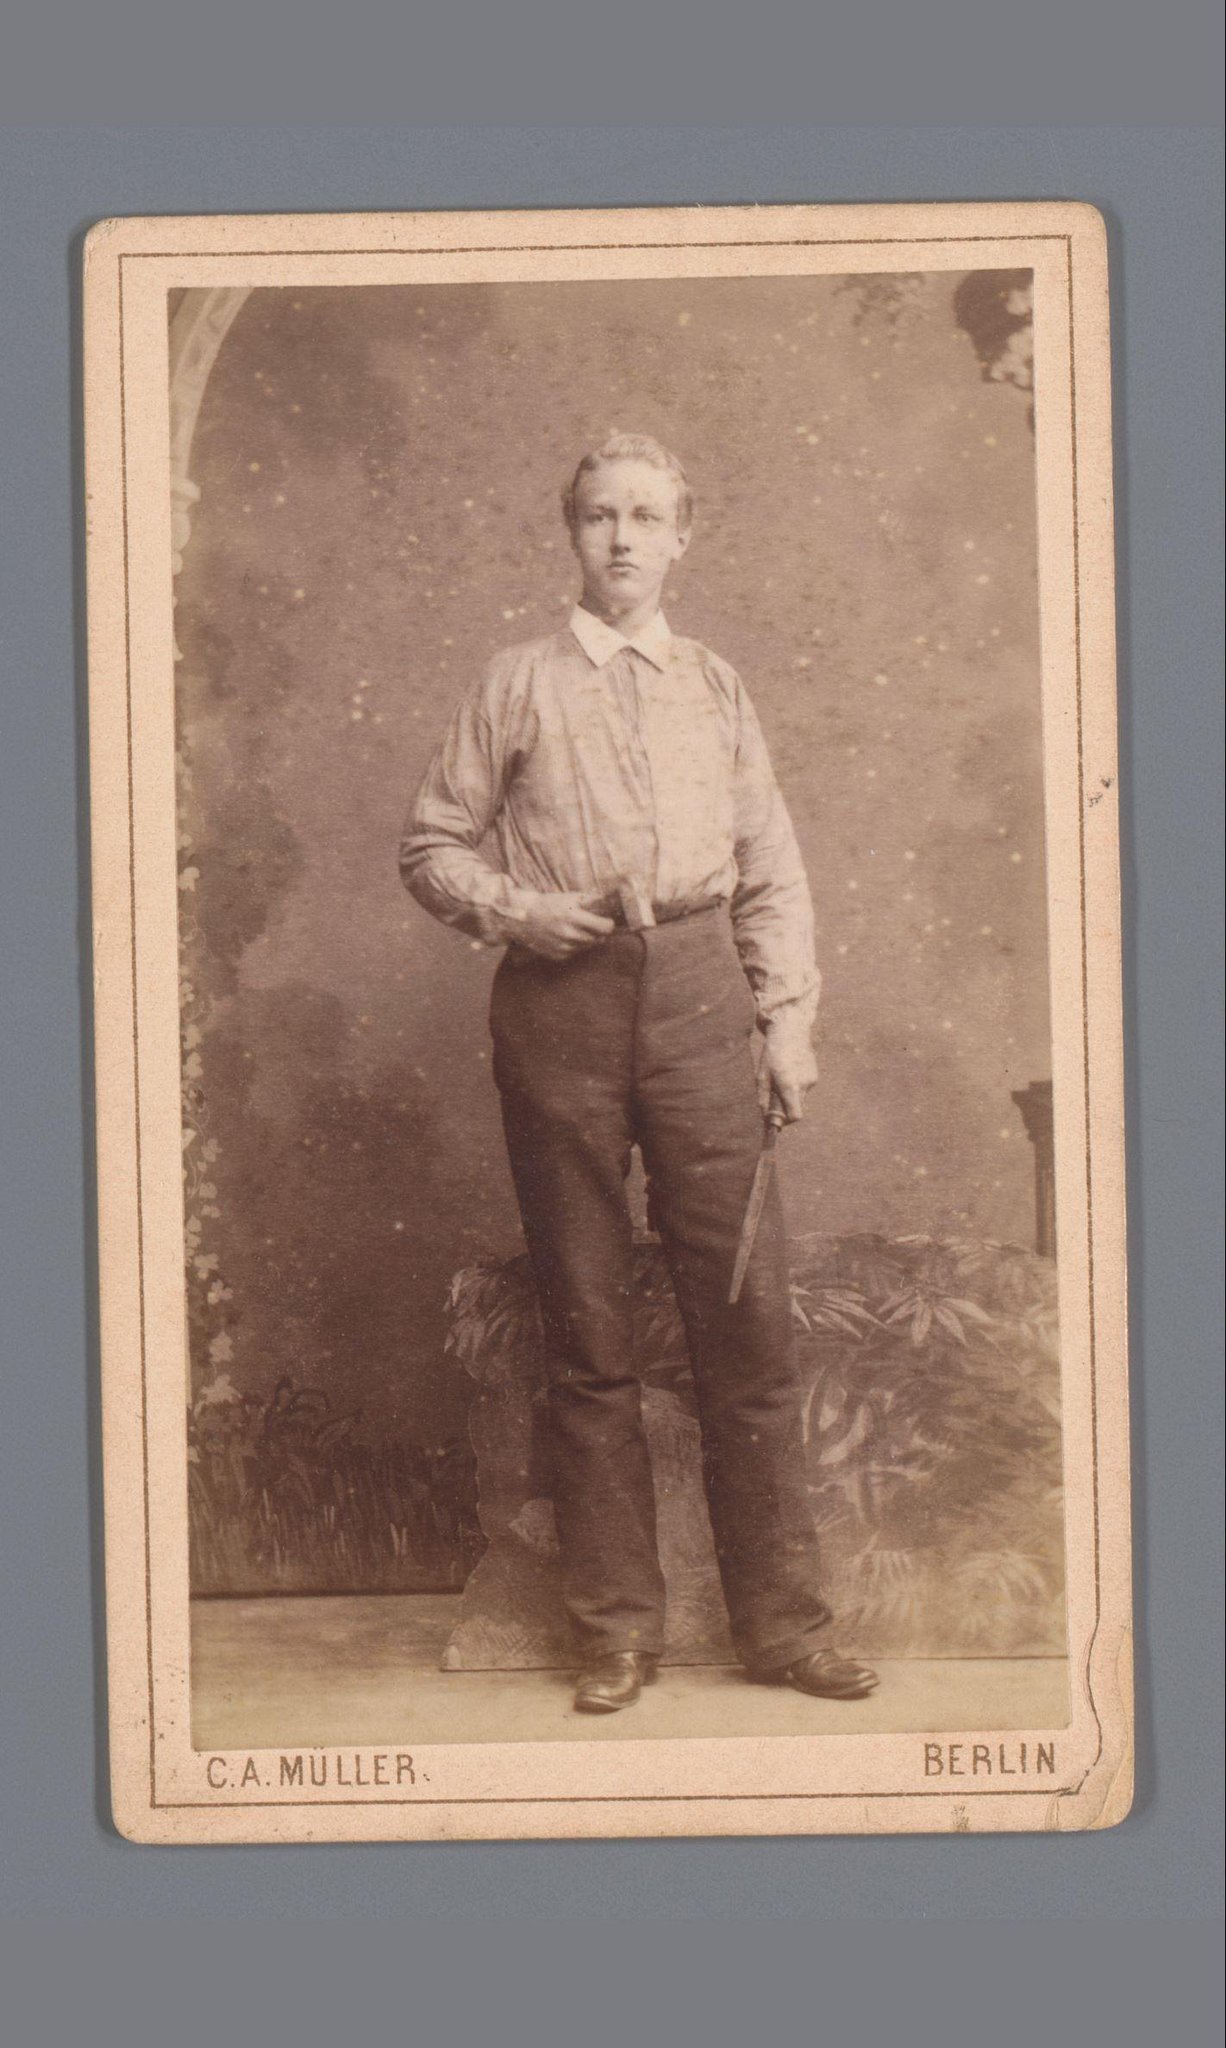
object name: photograph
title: Portret van een onbekende jonge man met hamer en vijl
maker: c.a. müller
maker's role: fotograaf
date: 1900-1914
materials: cardboard, paper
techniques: albumen print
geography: berlin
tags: youth, adolescent, anonymous historical person portrayed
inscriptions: inscription: ‘Specialität: Gruppen u. Vergrösserungen bis zu/ Lebengrösse.’, address: ‘No 40, Chaussee-Str. No 40,/ vis à vis dem mittleren Portal/ der Garde Füsilier-Kazerne.’